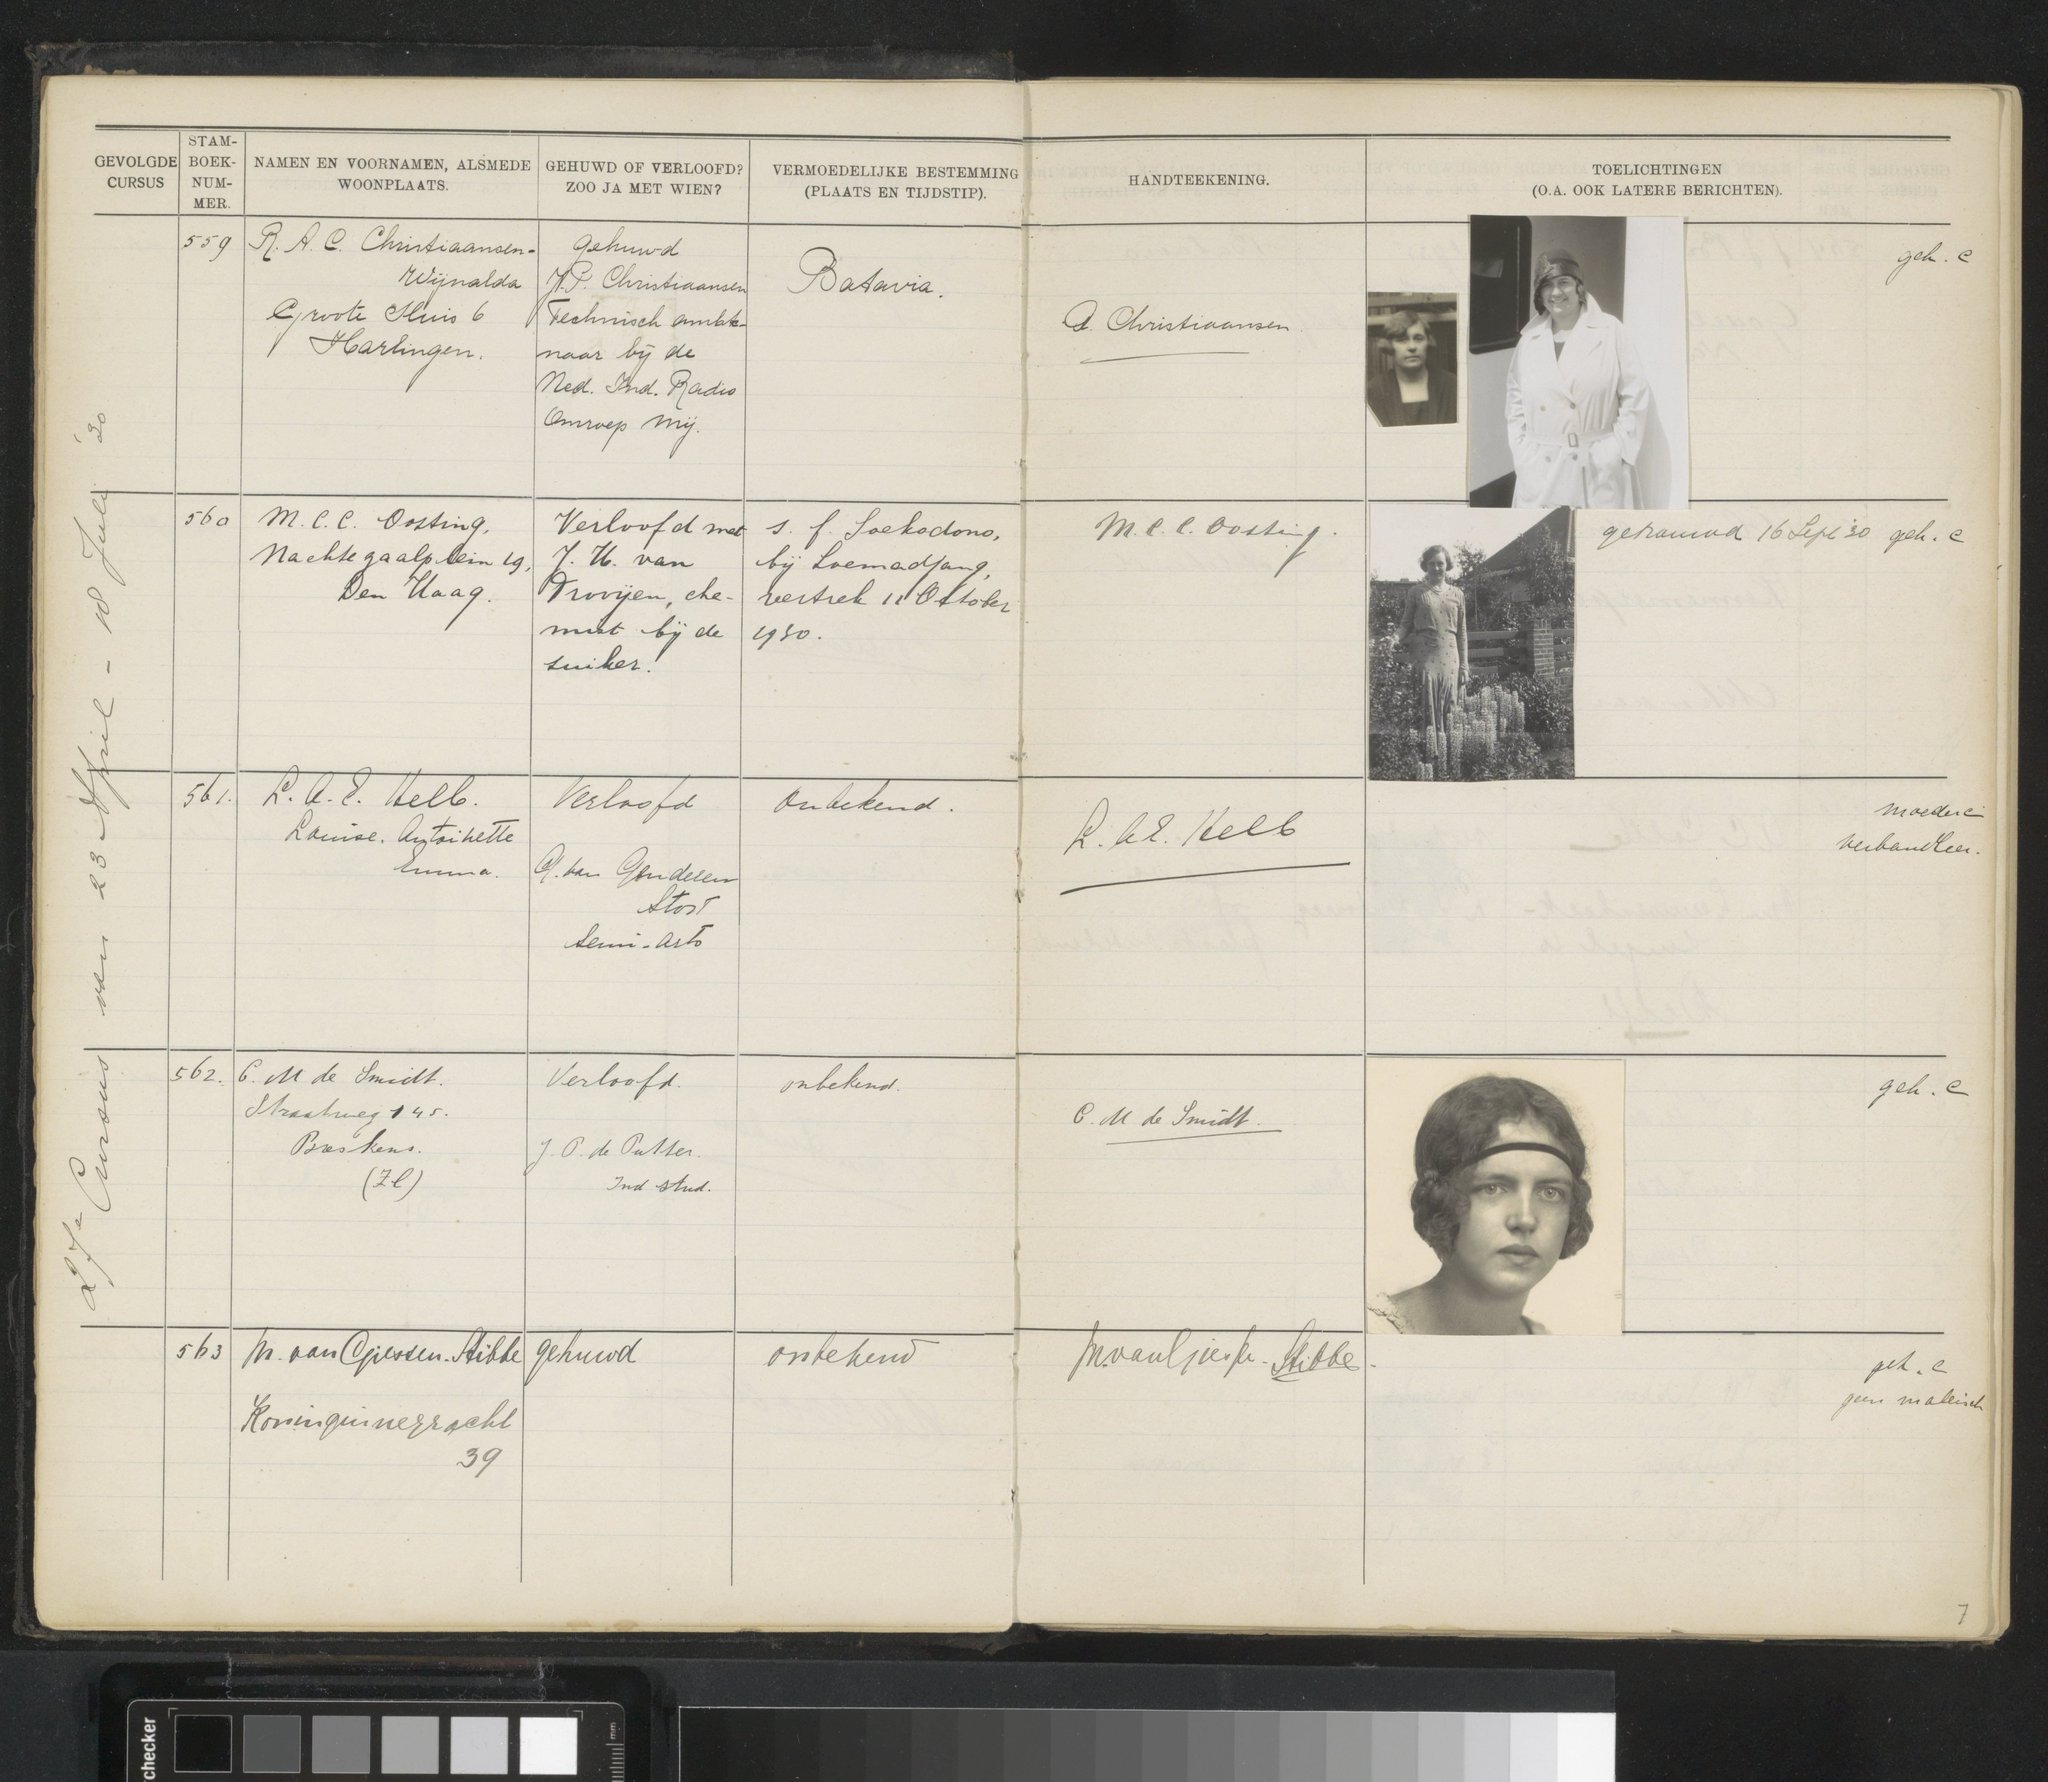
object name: photograph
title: Blad 7 uit Stamboek van de leerlingen der Koloniale School voor Meisjes en Vrouwen te 's-Gravenhage deel II (1930-1949)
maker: Anonymous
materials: paper, photographic support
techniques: photography, printing, writing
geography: the hague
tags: further education (+ pupil), further education, the hague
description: Twee pagina's met gegevens van de deelnemers aan de 27e driemaandelijkse cursus van 23 april 1930 tot en met 18 juli 1930, stamboeknummers 559 tot en met 563. Onderdeel van Stamboek van de leerlingen der Koloniale School voor Meisjes en Vrouwen te 's-Gravenhage deel II (1930-1949).